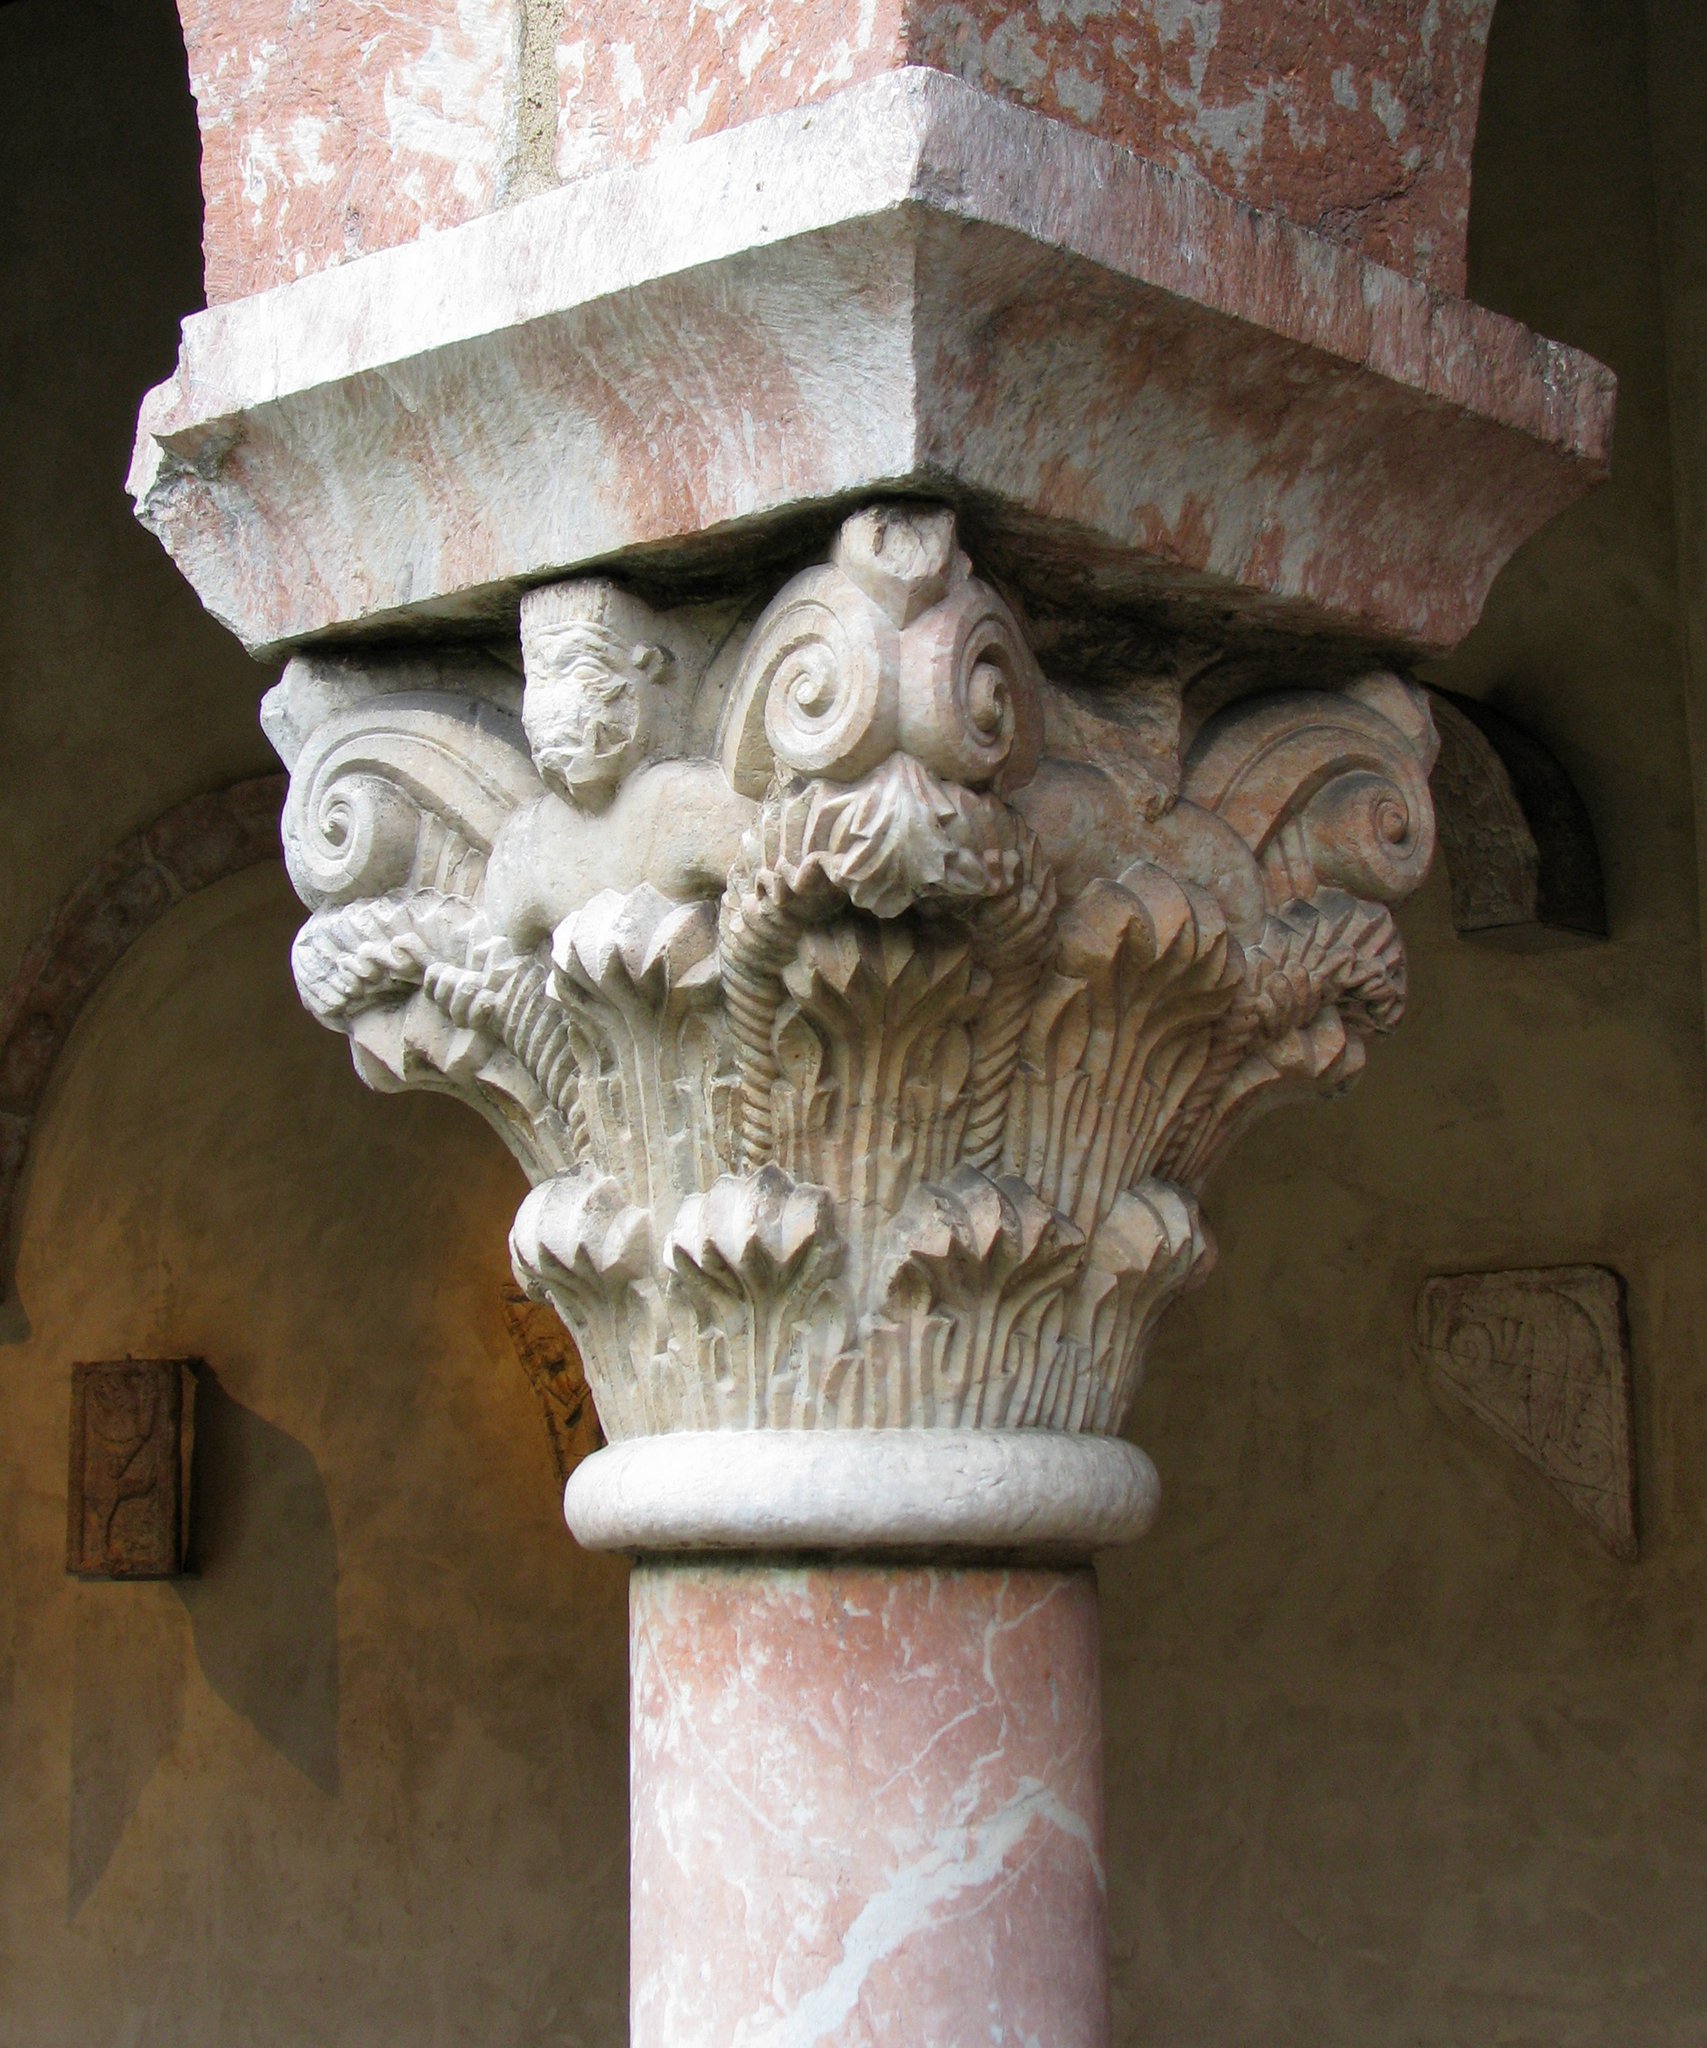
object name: capital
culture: catalan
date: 1130-1140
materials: marble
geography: france